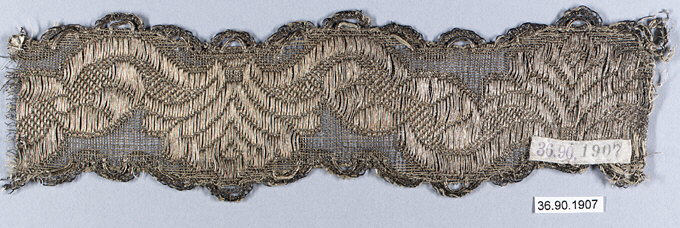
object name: galloon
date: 1767-1833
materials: metal thread